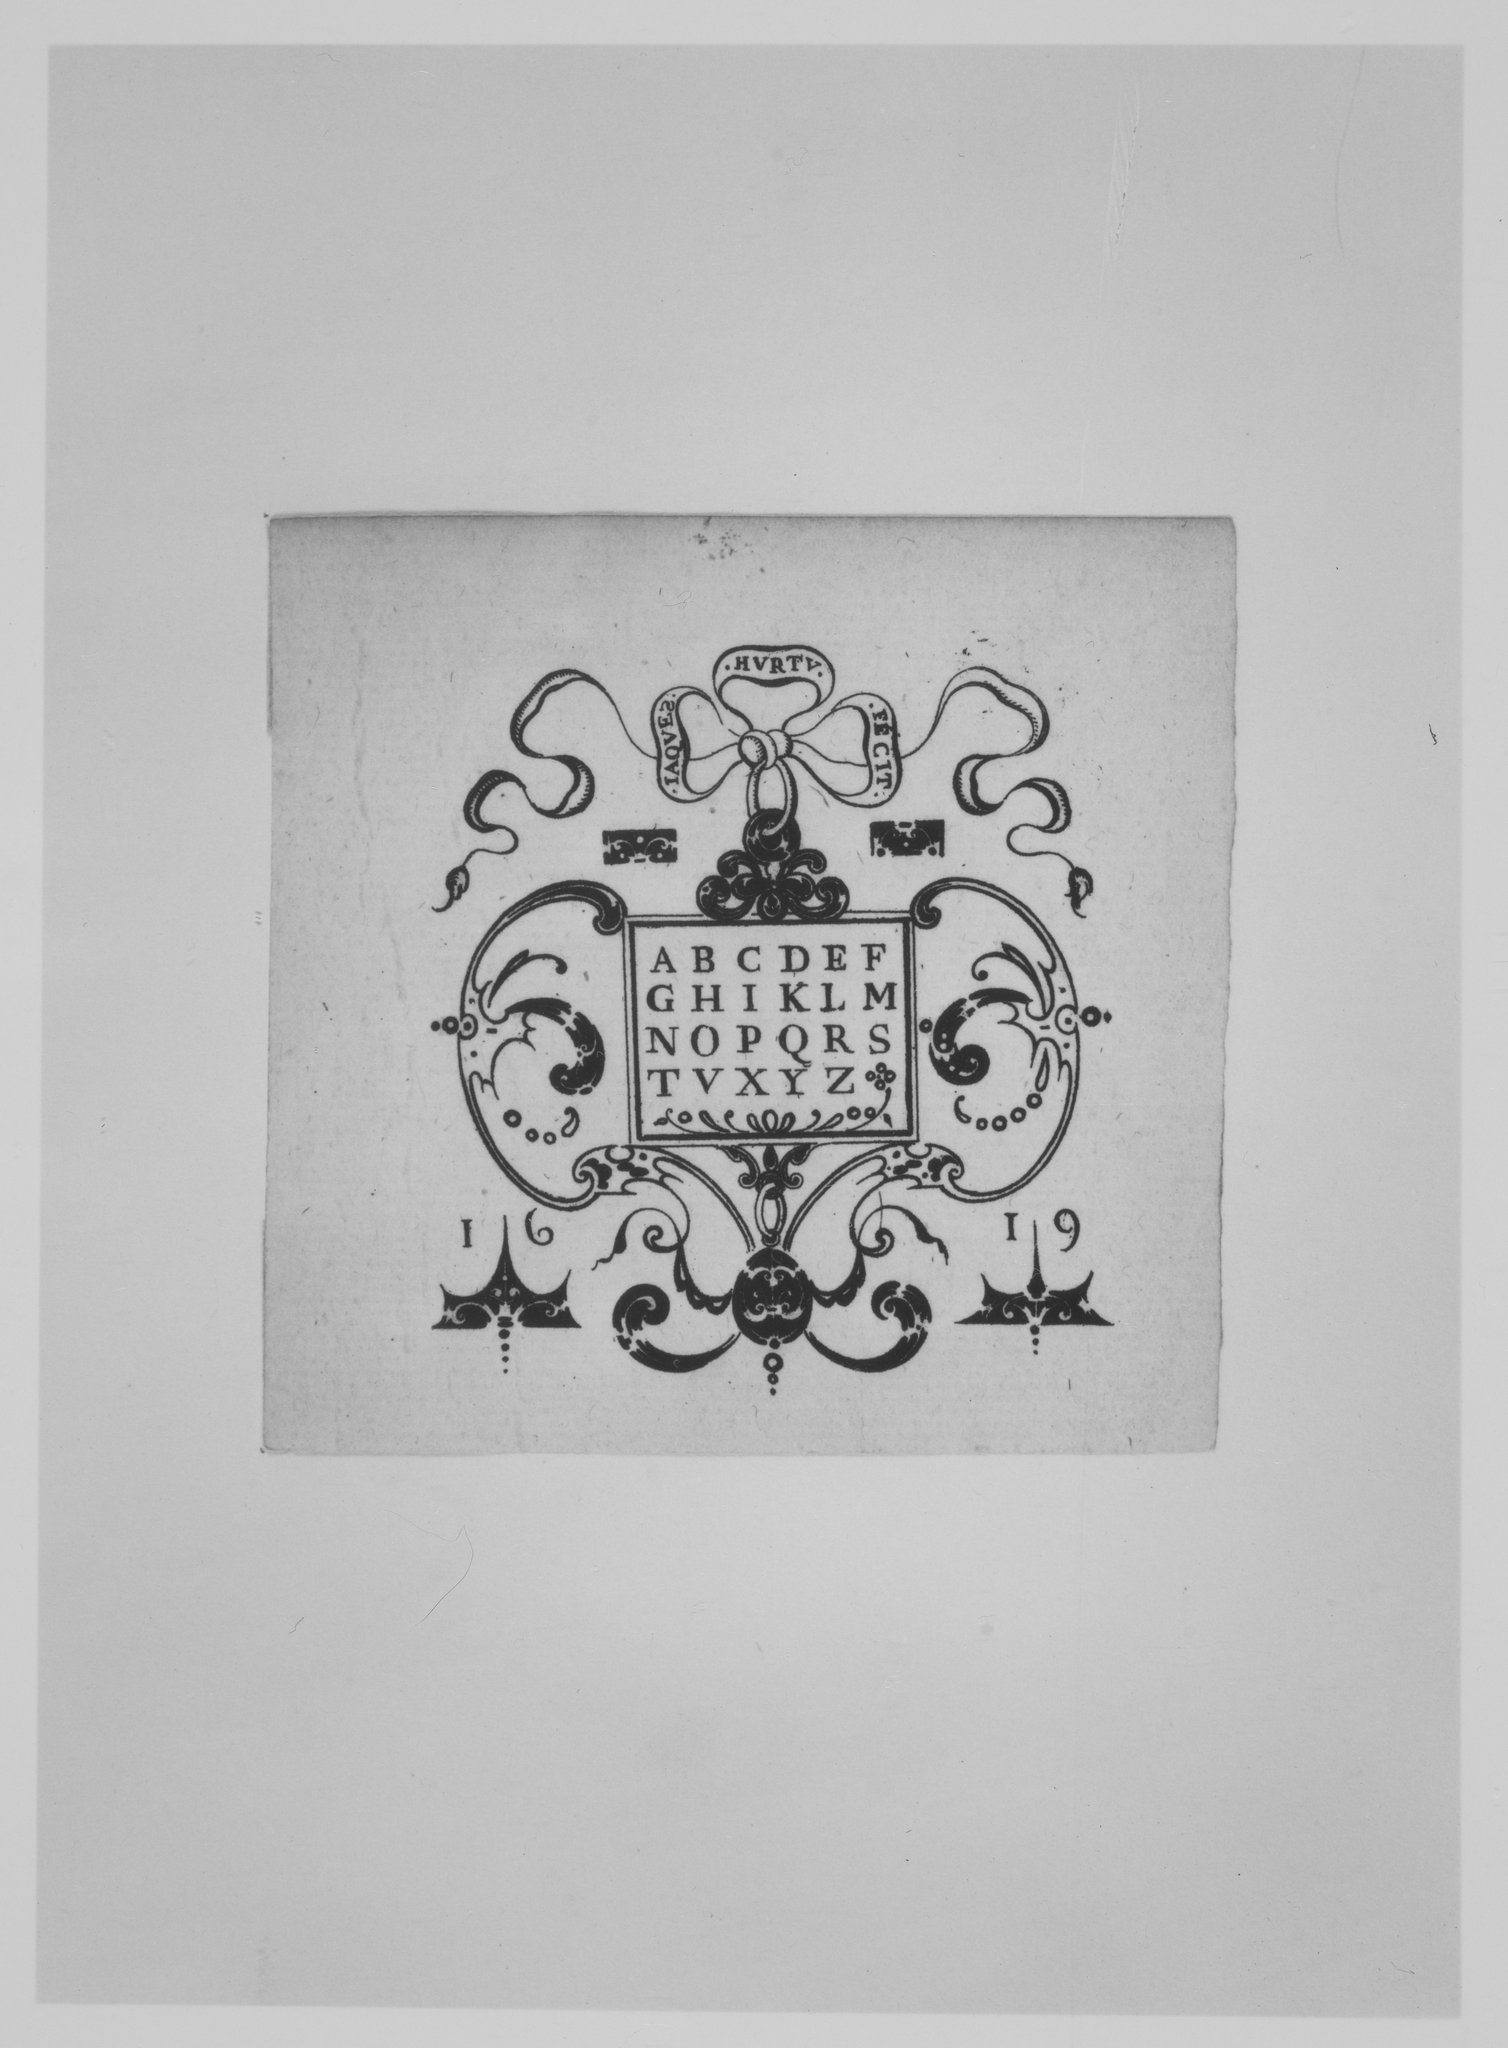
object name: print ornament architecture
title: Alphabet Surrounded by Decorative Ornamentation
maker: jacques hurtu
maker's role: artist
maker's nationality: french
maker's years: 1584-1635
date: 1619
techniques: embroidery, engraving